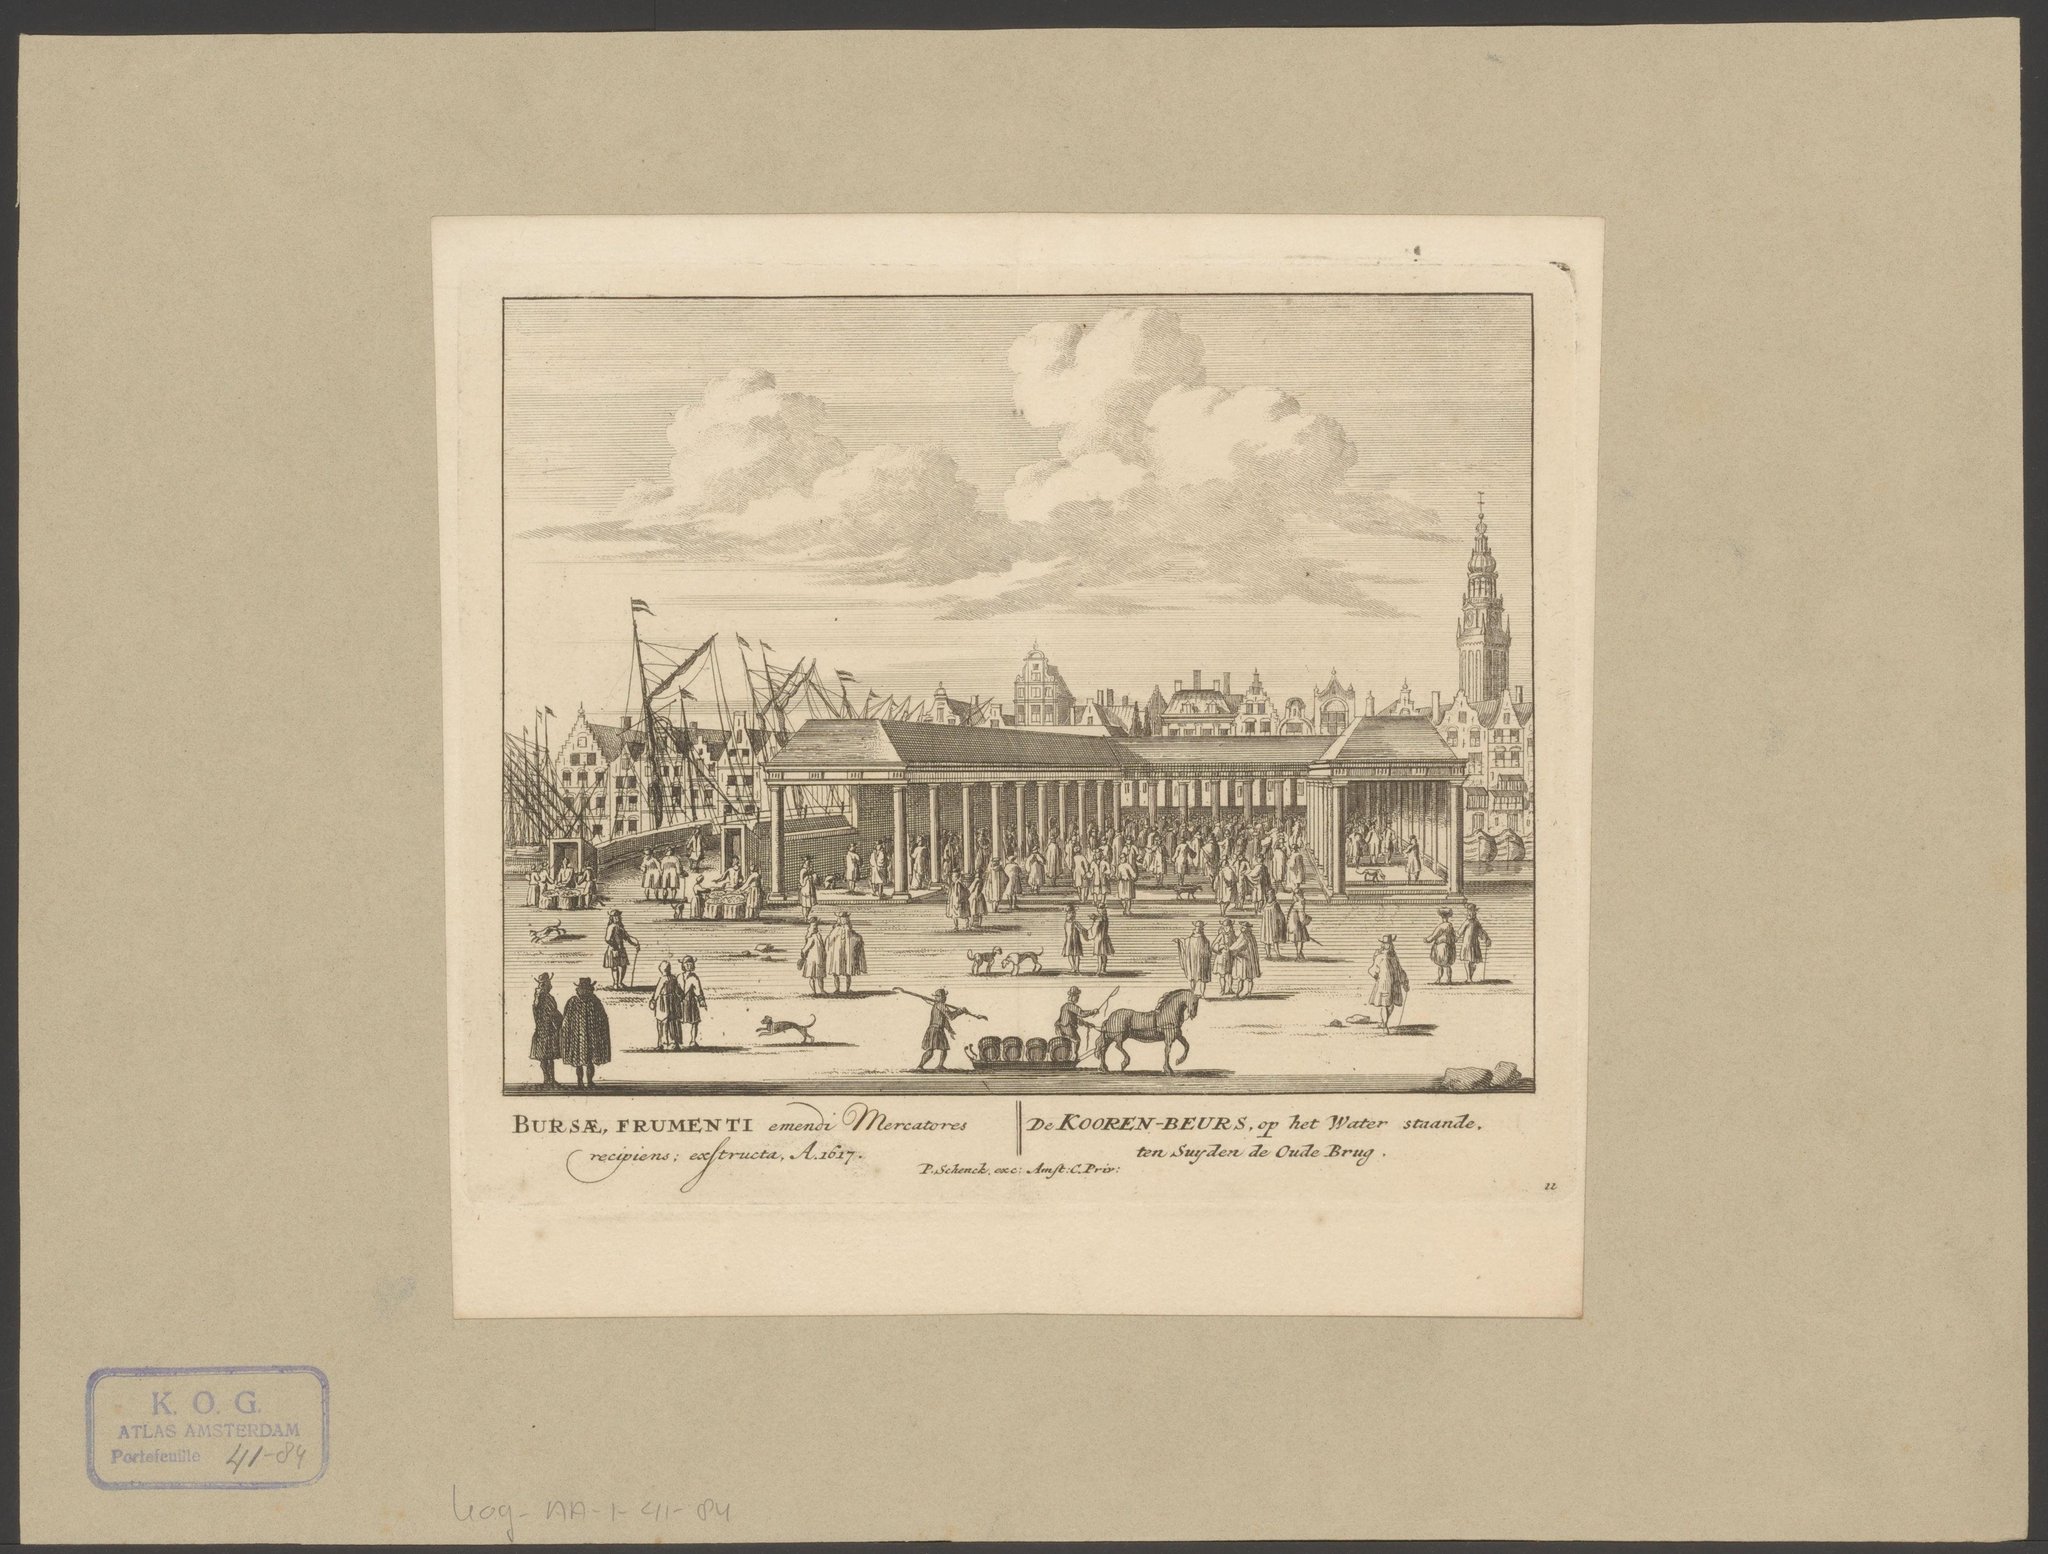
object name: print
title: De Kooren-Beurs, op het Water staande, ten Suyden de Oude Brug / Bursae, frumenti emendi Mercatores recipiens; exstructa, A. 1617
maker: Anonymous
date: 1710-1711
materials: paper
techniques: engraving, etching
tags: sailing-ship, sailing-boat, market-hall, parts of church exterior and annexes: tower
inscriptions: collector's mark: ‘41-84’ Lugt 1641b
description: Prent uit: 100 Afbeeldinge der voornaamste gebouwen van Amsterdam. Amsterdam: Pieter Schenk (I), s.a. [1710-1711]. Of uit: 100 Afbeeldinge der voornaamste gebouwen van Amsterdam. Amsterdam: Barent Greve, s.a. [1757-1766].* *In de tweede uitgave, uitgegeven door Barent Greve, is alleen de titelprent aangepast. De overige prenten zijn onveranderd gebleven.